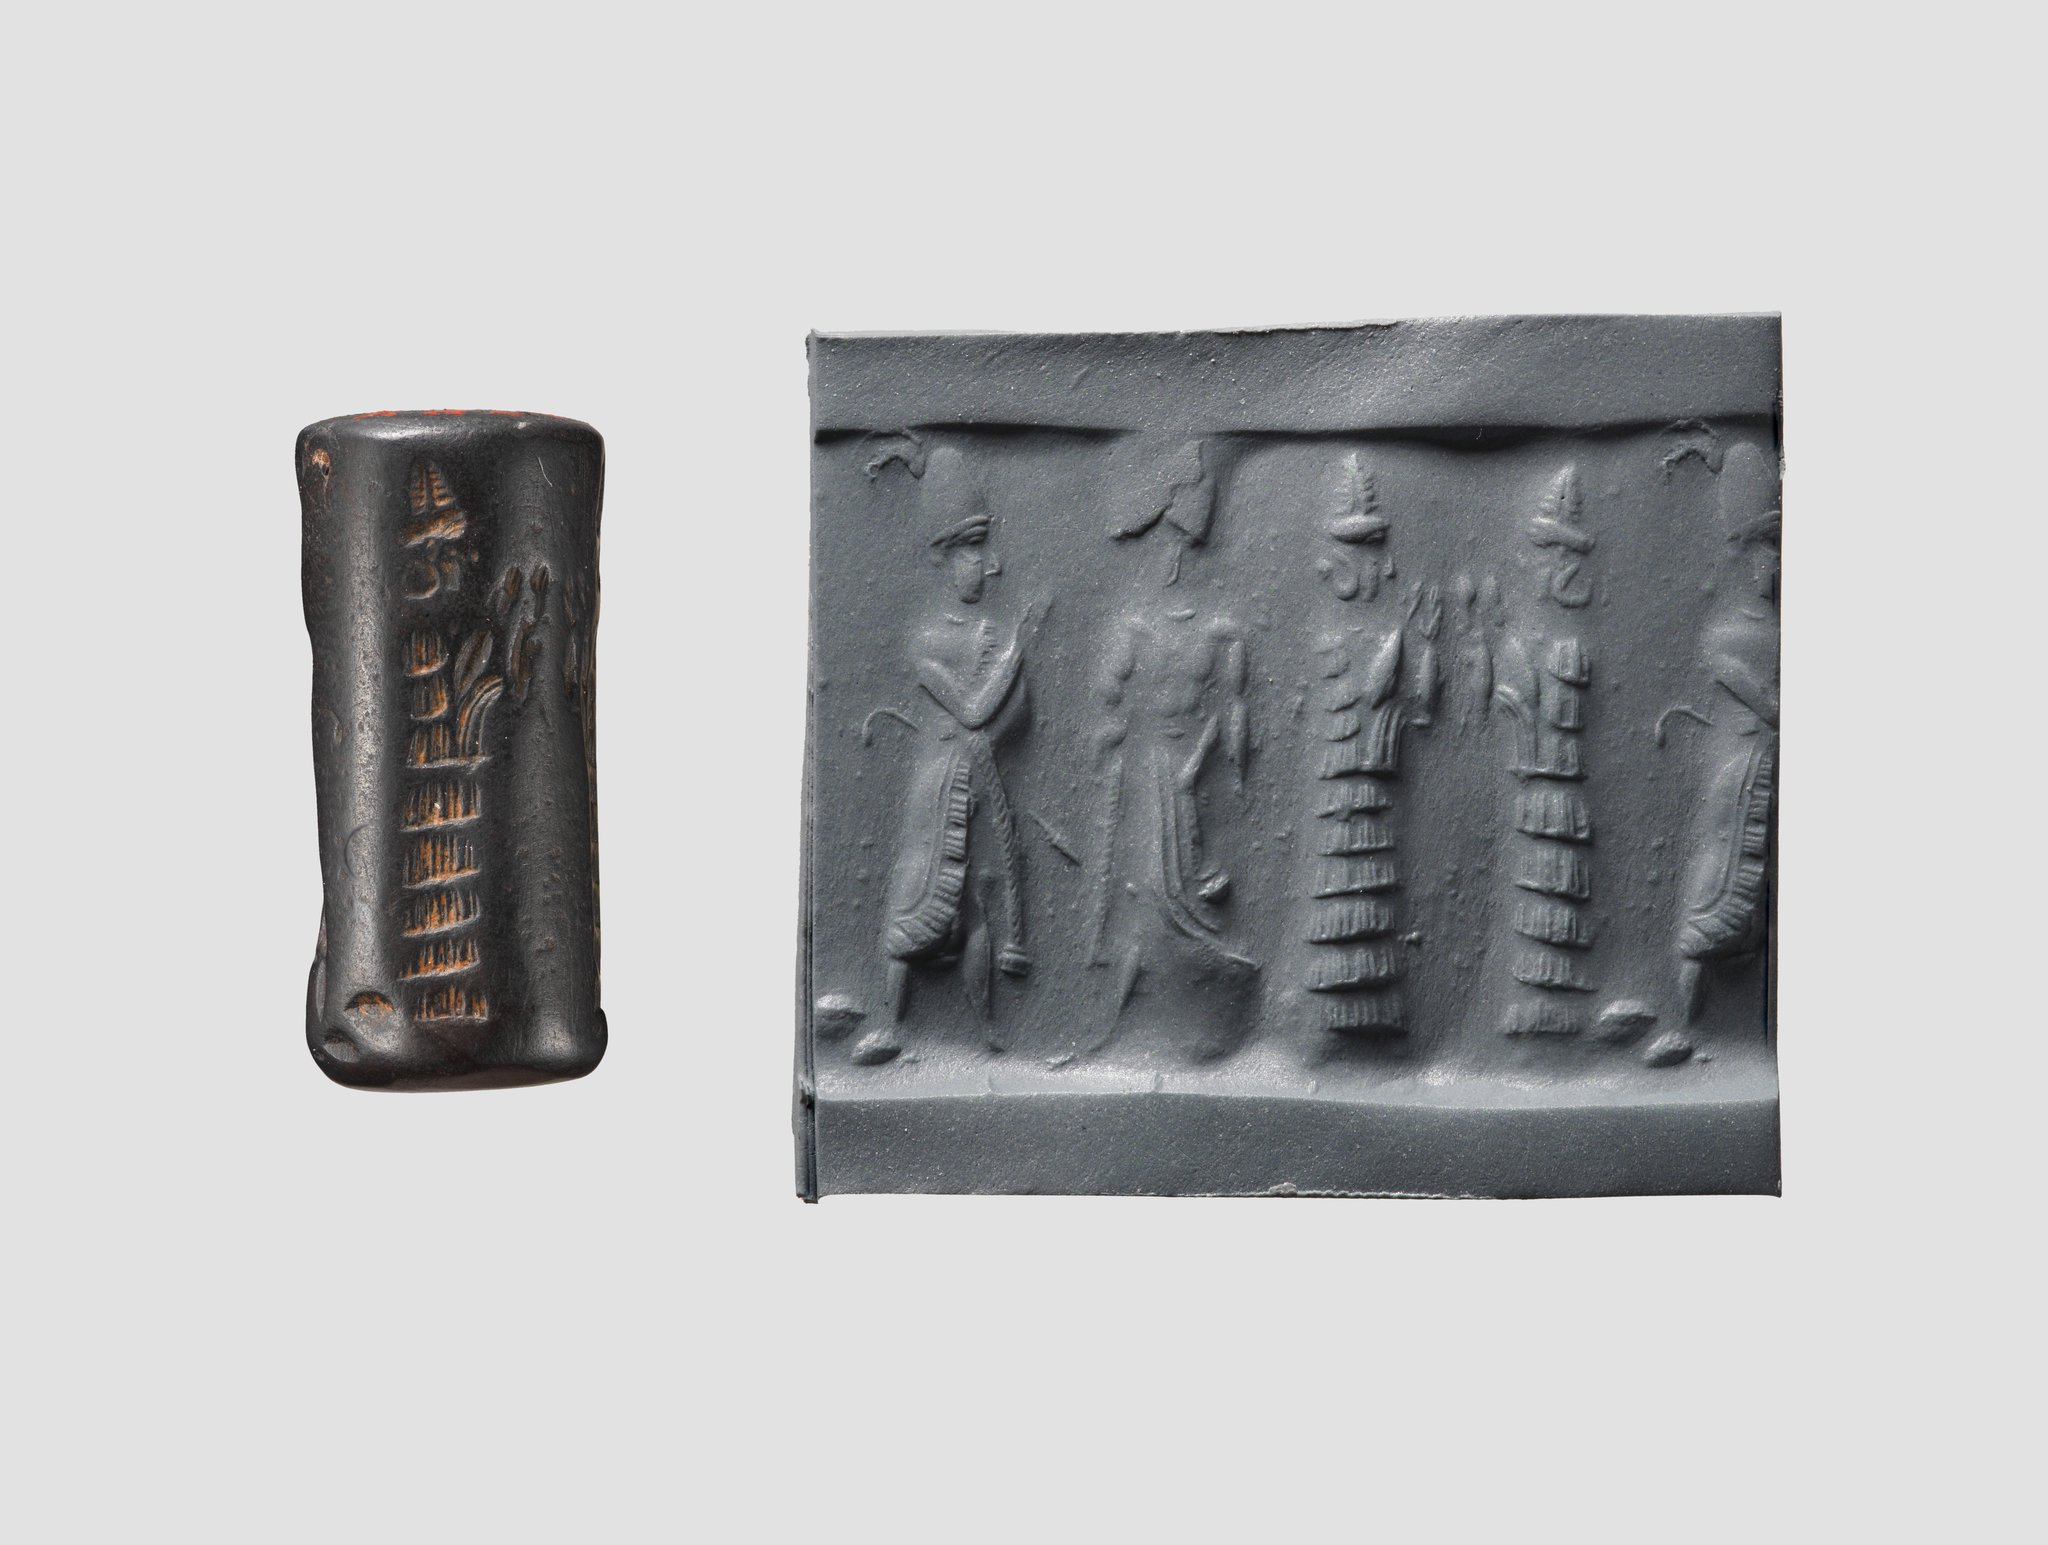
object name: cylinder seal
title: Cylinder seal and modern impression: suppliant goddesses and worshipers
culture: babylonian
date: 2000-1668 BCE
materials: mineral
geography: mesopotamia or syria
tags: goddess